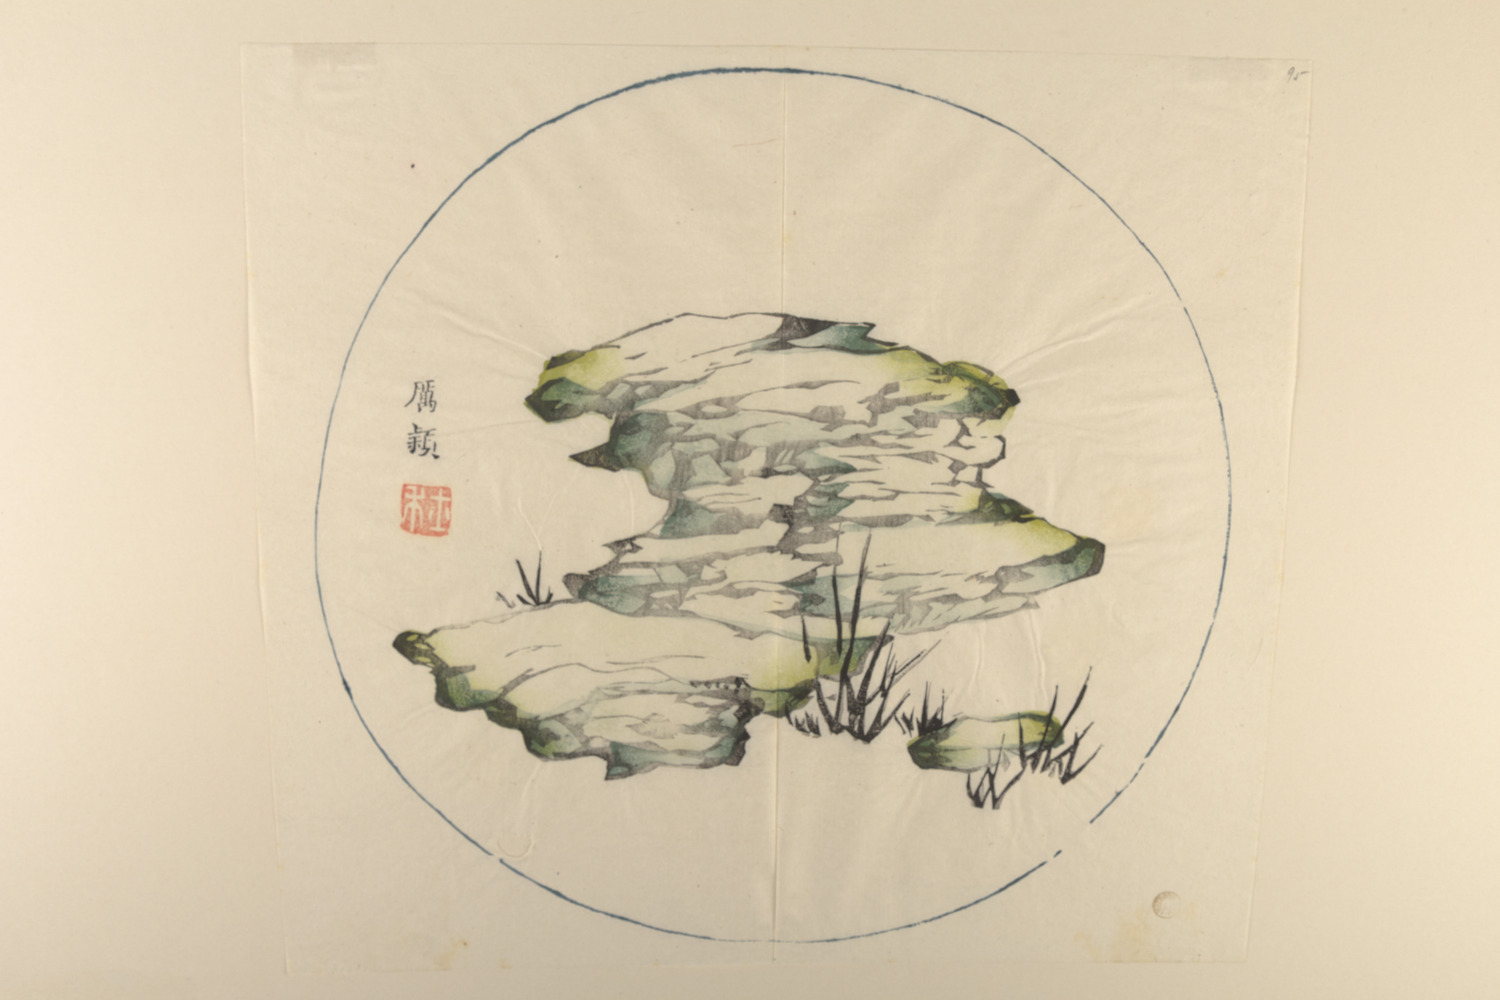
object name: print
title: Page from Shi Zhu Zhai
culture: chinese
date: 1736-1795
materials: ink, paper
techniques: polychrome, woodblock print